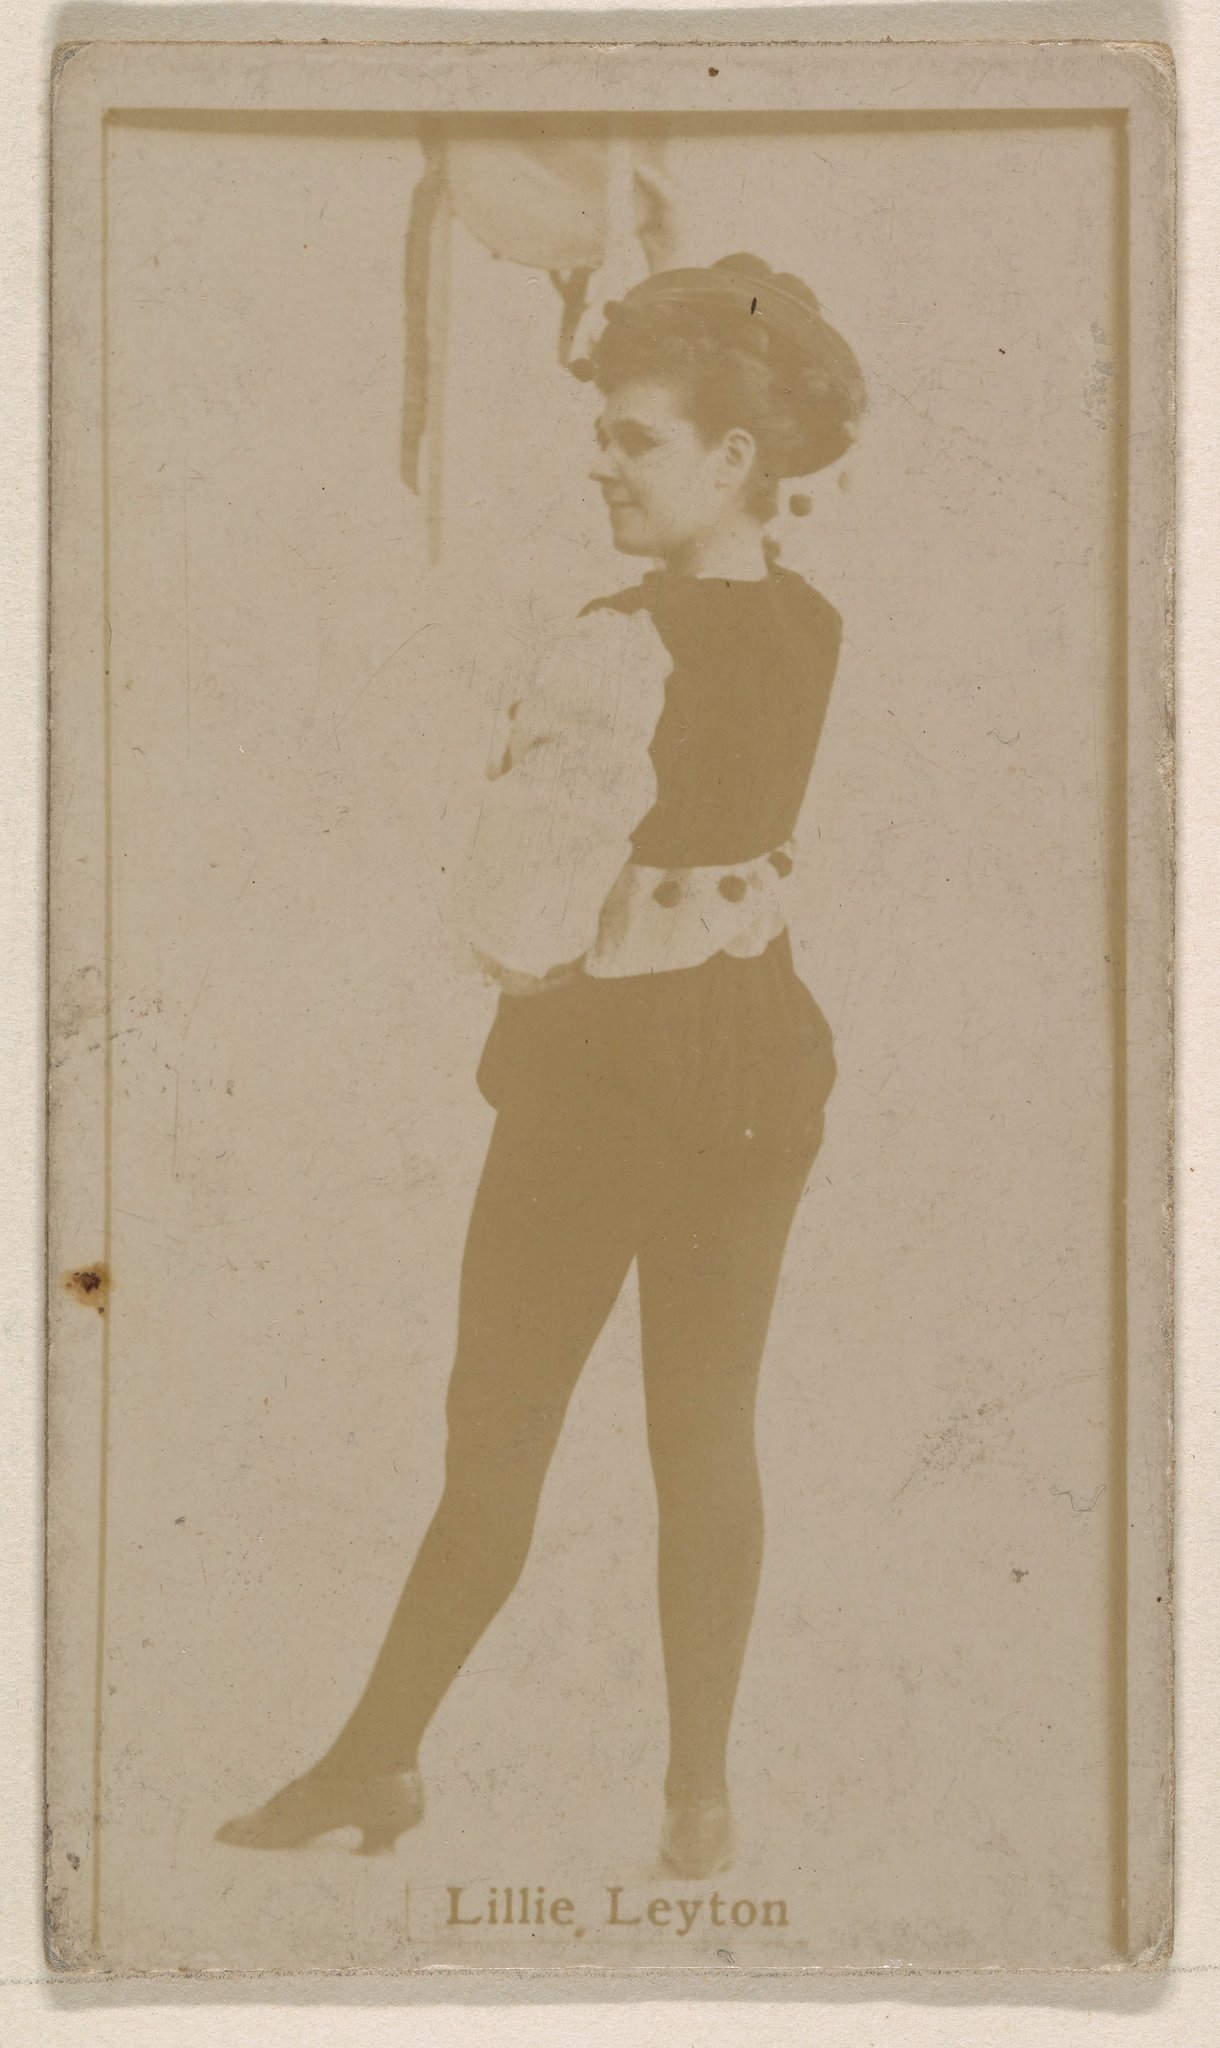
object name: photograph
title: Lillie Leyton, from the Actresses series (N245) issued by Kinney Brothers to promote Sweet Caporal Cigarettes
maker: kinney brothers tobacco company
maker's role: publisher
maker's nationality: american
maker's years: 1869-2011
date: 1890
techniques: albumen silver print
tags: women,actresses